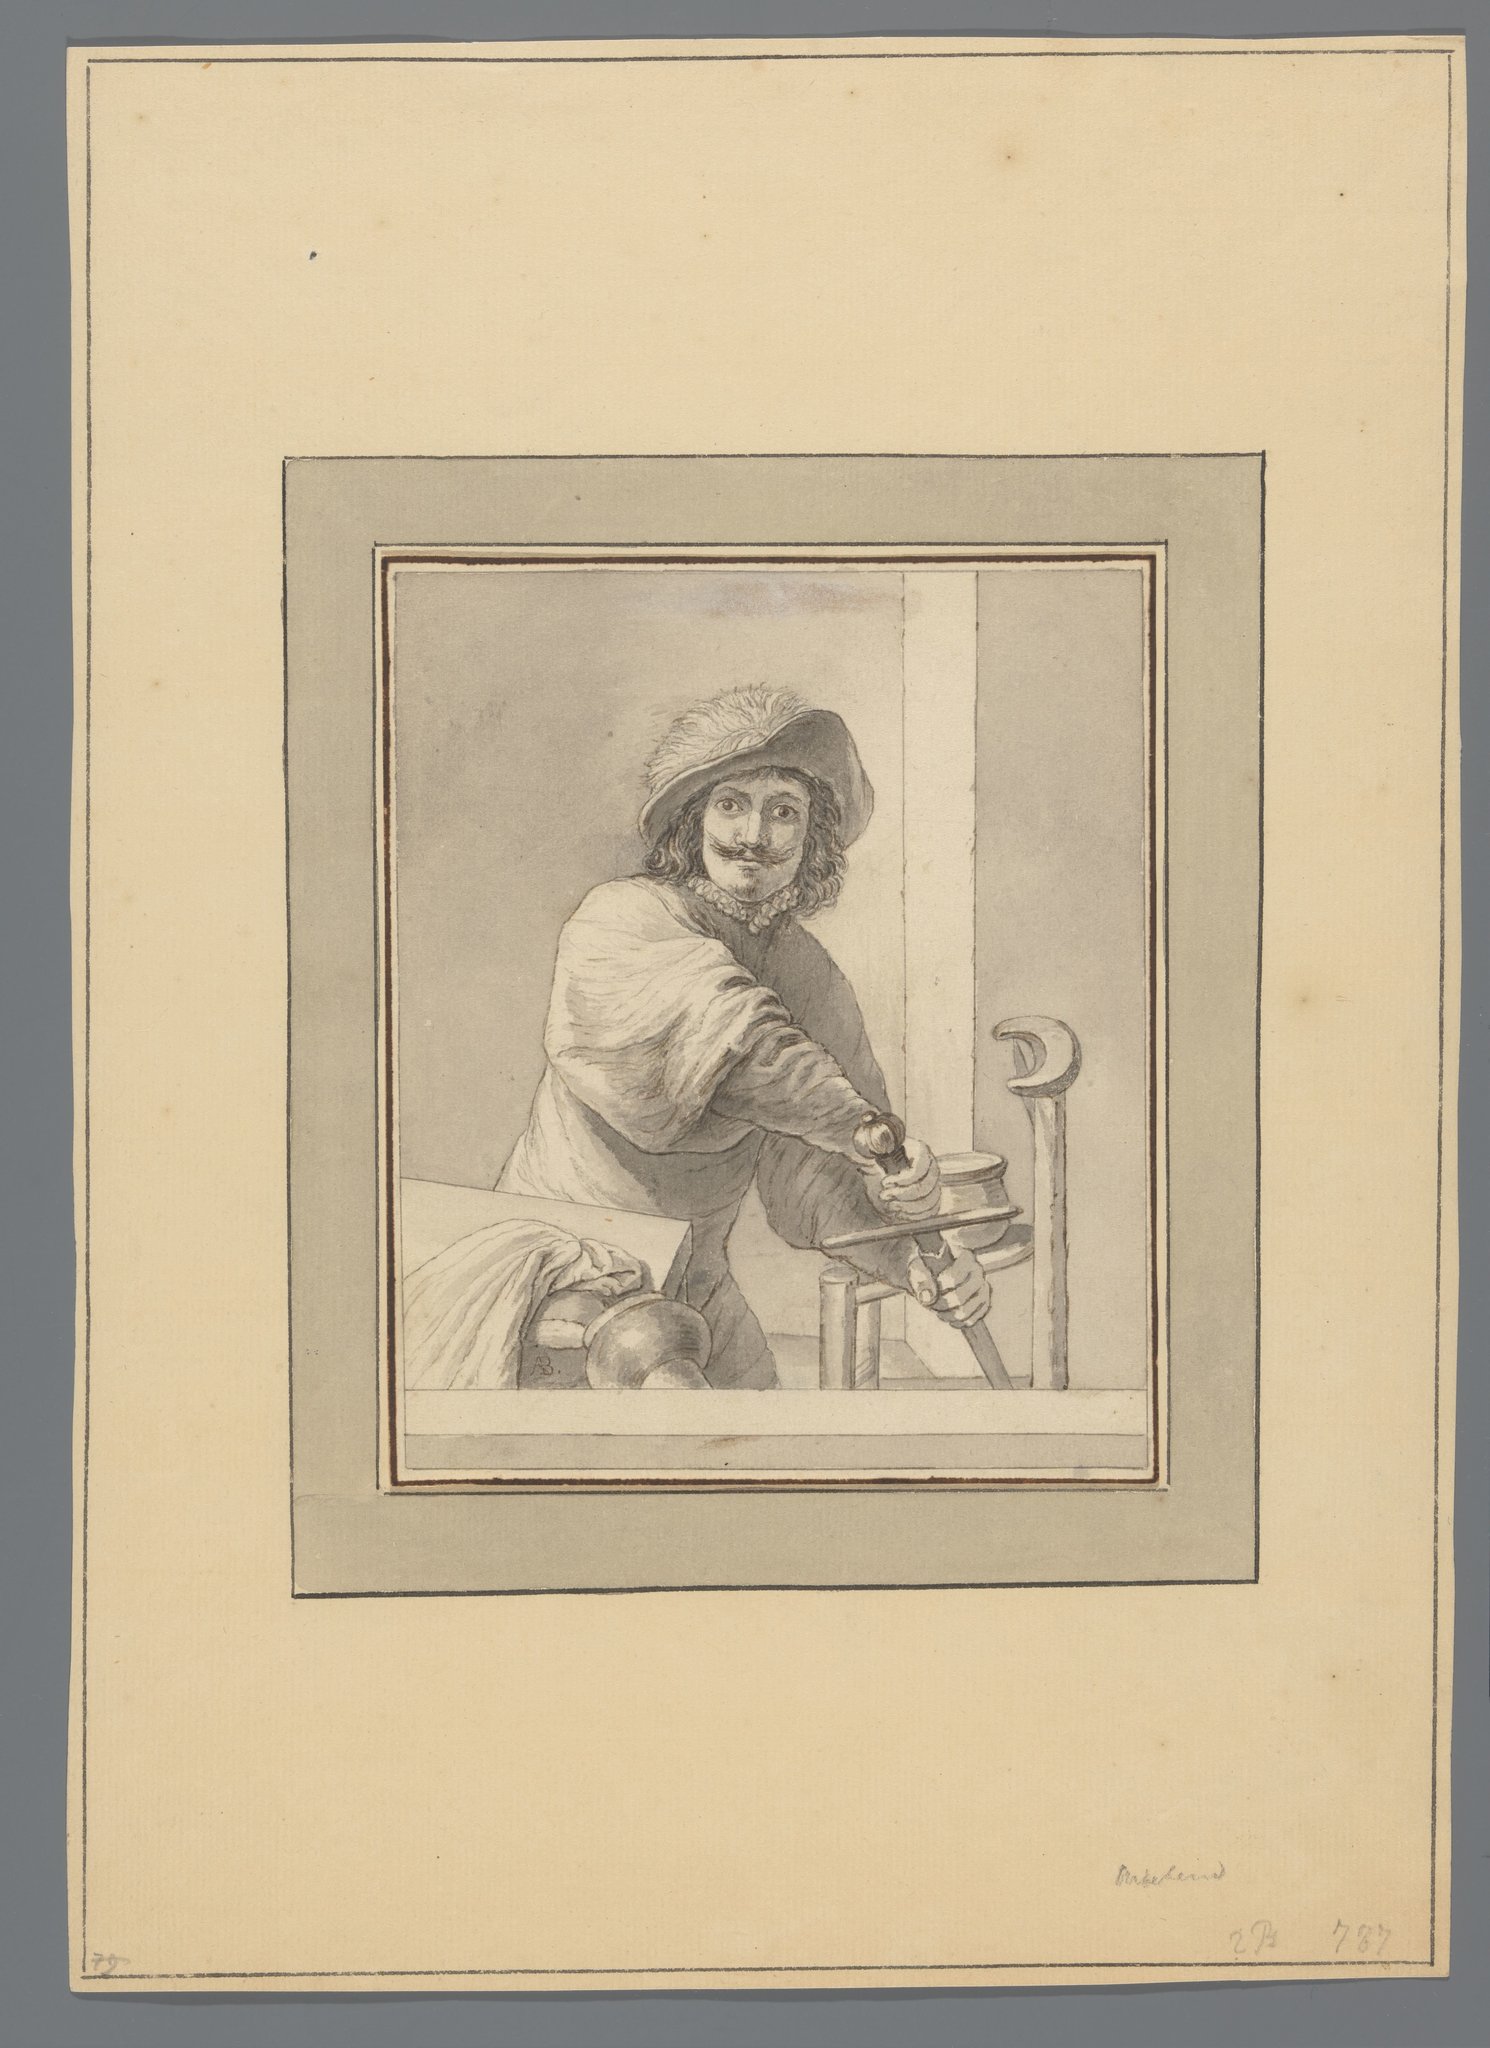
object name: drawing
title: Soldaat trekt zijn zwaard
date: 1615-1688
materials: ink, paper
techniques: brush, pen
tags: the soldier off duty